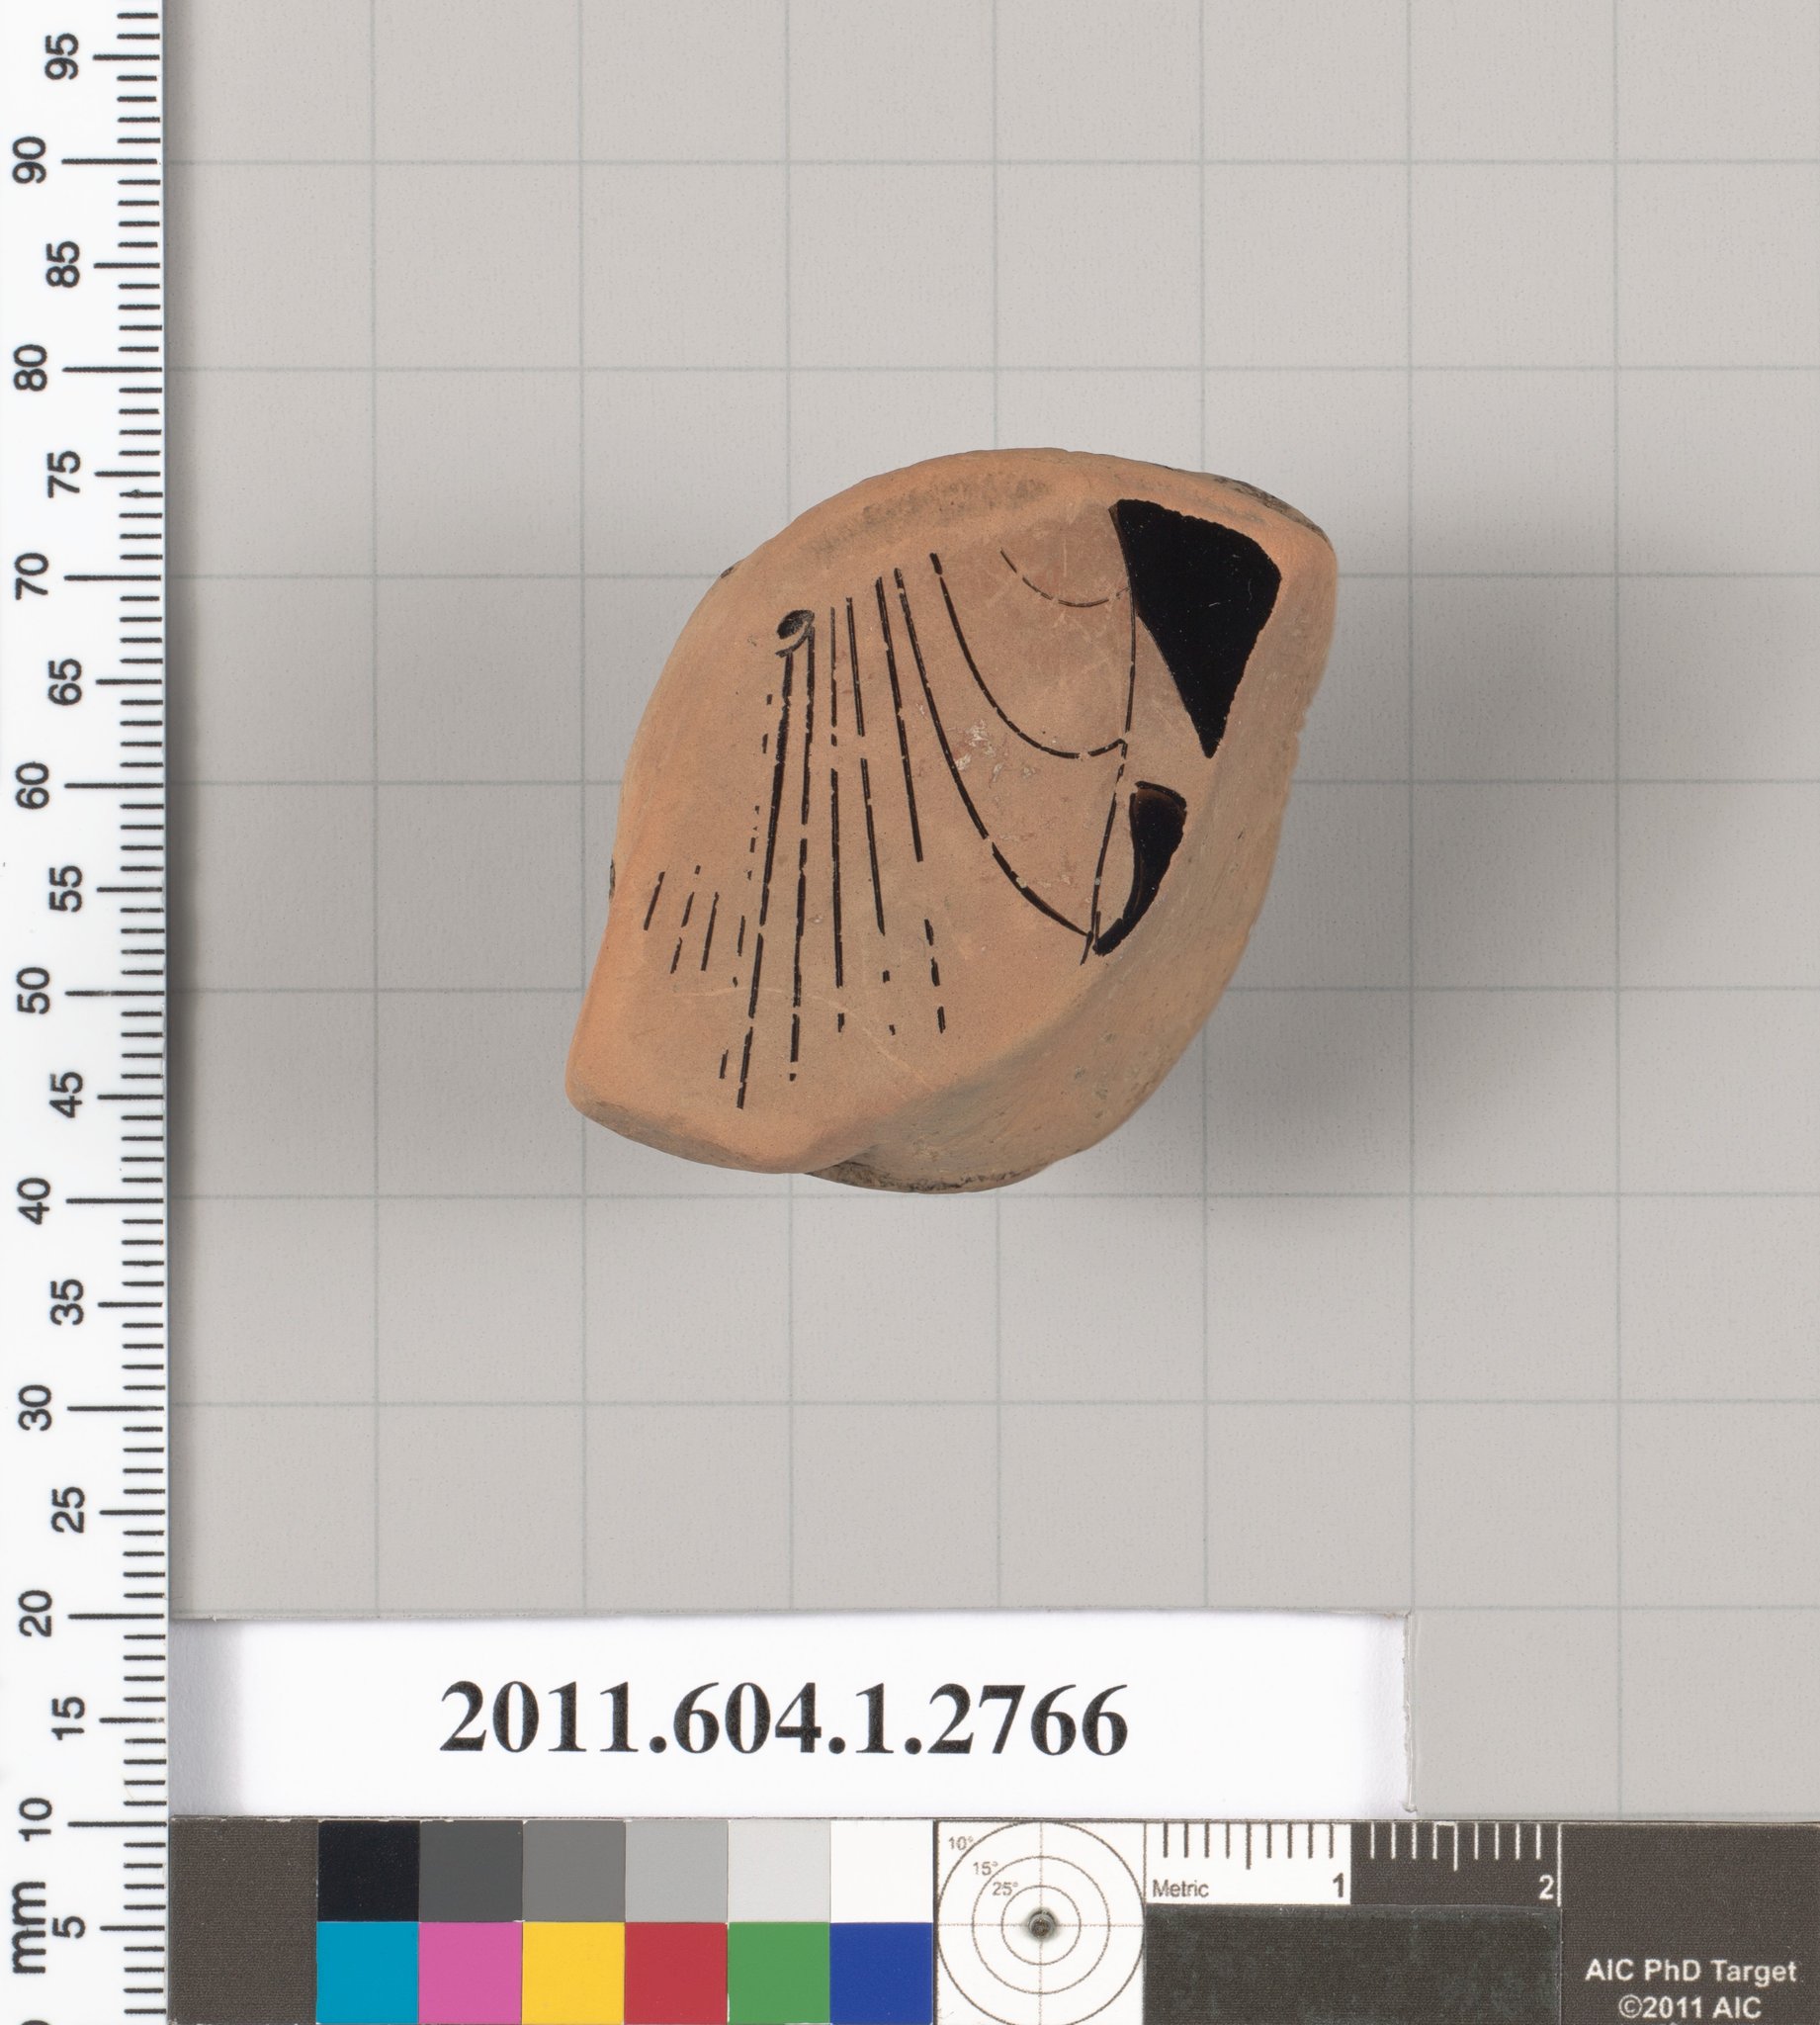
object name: kylix fragment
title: Terracotta fragment of a kylix (drinking cup)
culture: greek, attic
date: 475-451 BCE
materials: terracotta